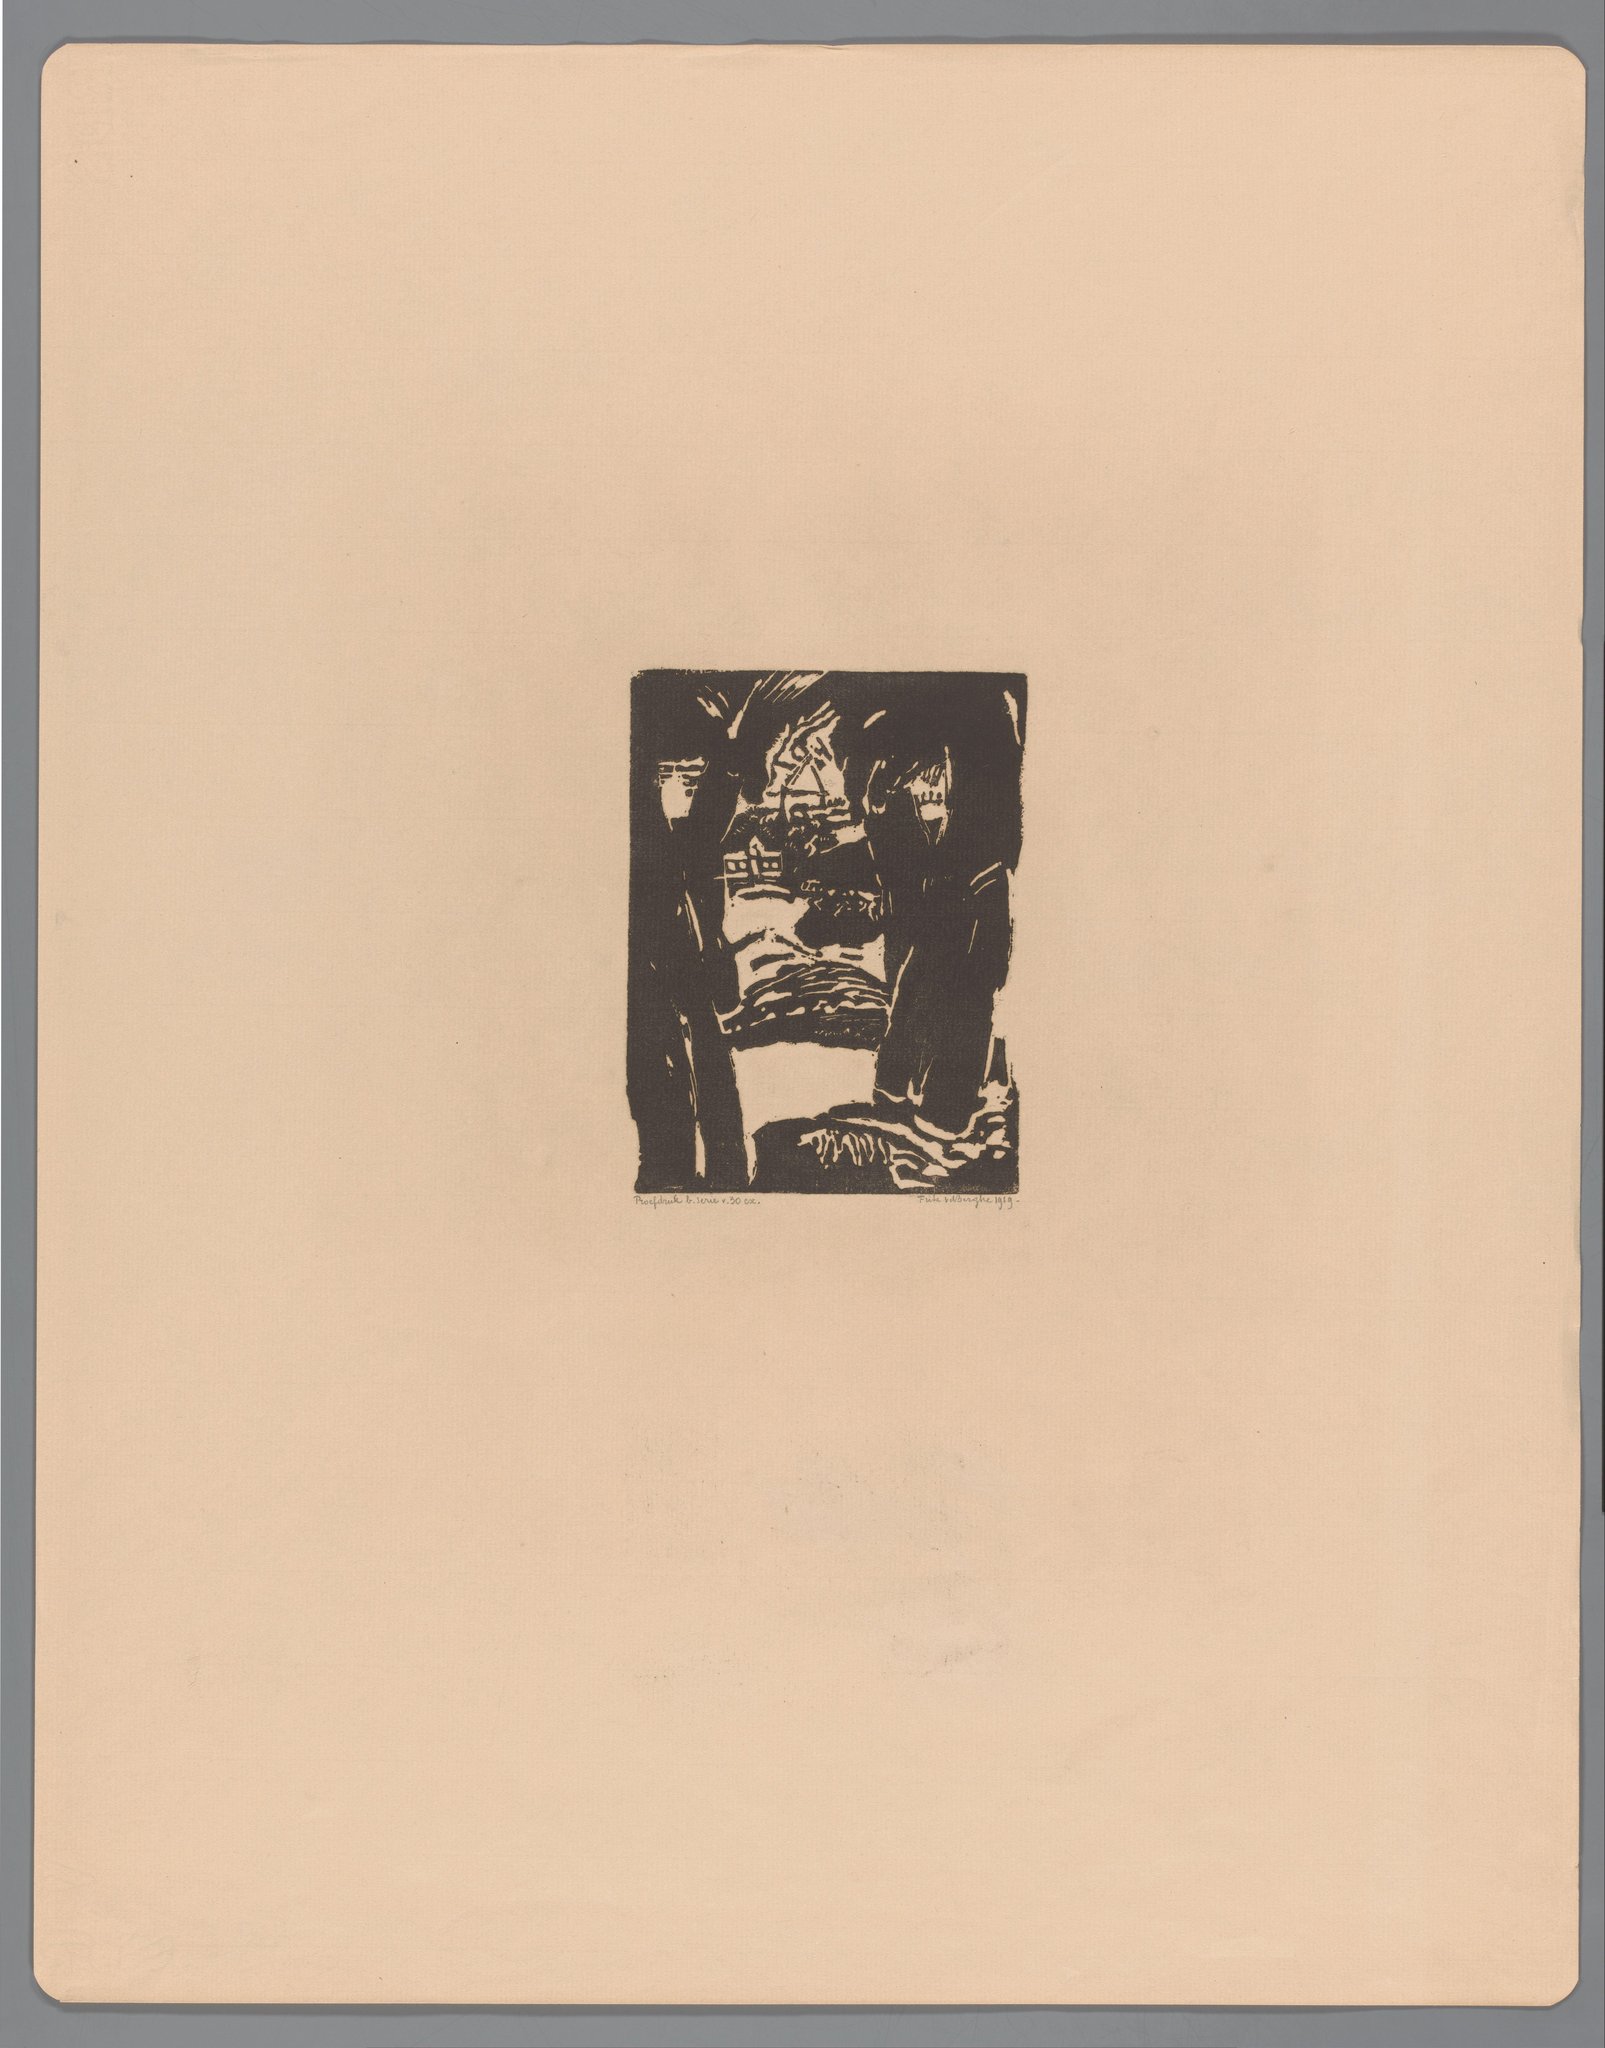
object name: print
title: Gezicht op huizen tussen bomen door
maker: frits van den berge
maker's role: print maker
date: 1919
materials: paper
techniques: woodcut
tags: trees, rural housing, e.g. country-house, villa, cottage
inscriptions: collector's mark: Lugt 2228, annotation: ‘Proefdruk v. serie v. 35 exempl.’